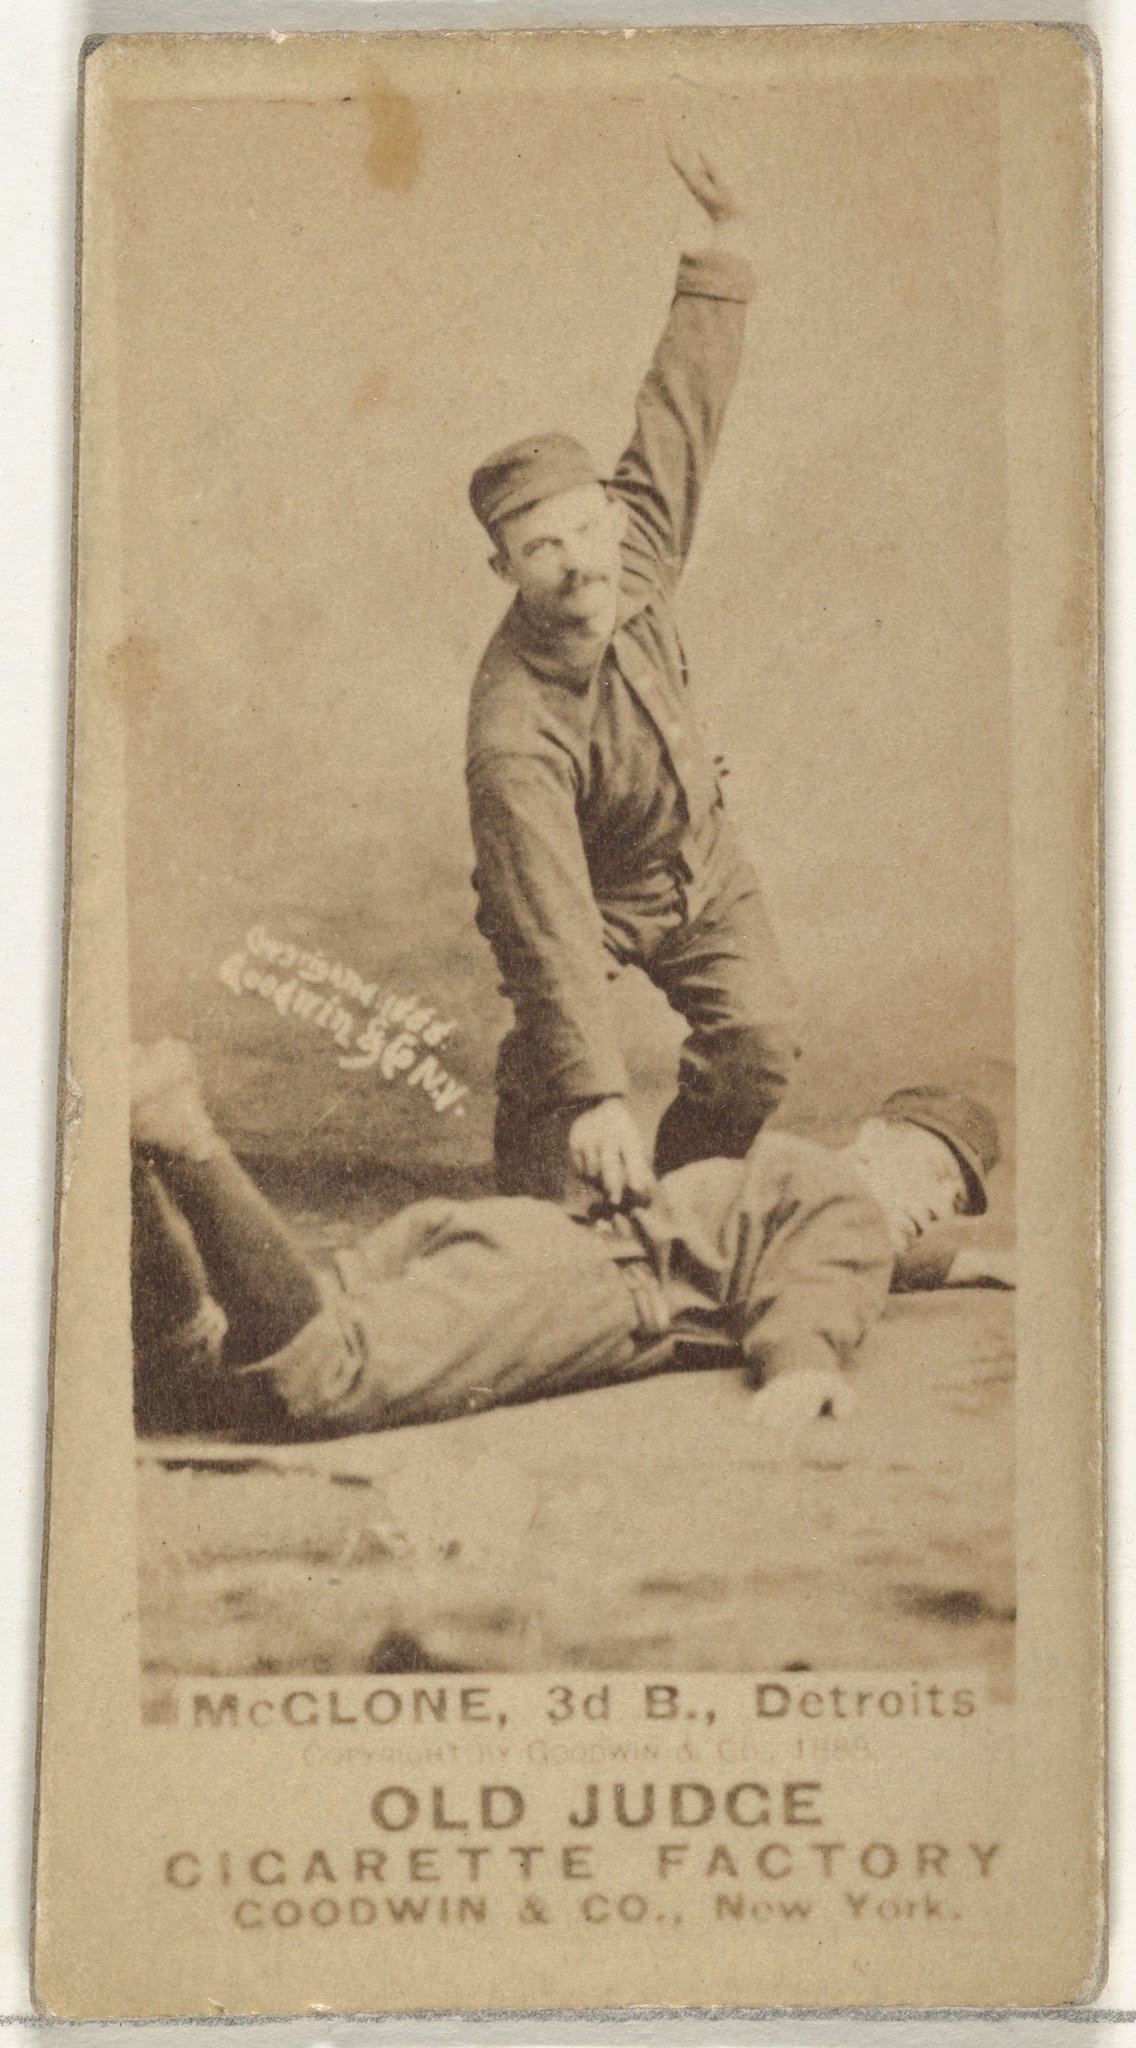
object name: baseball card, photograph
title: McGlone, 3rd Base, Detroit Wolverines, from the Old Judge series (N172) for Old Judge Cigarettes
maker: goodwin & company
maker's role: publisher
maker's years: 1850-1950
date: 1888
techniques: albumen silver print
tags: men,portraits,baseball,athletes